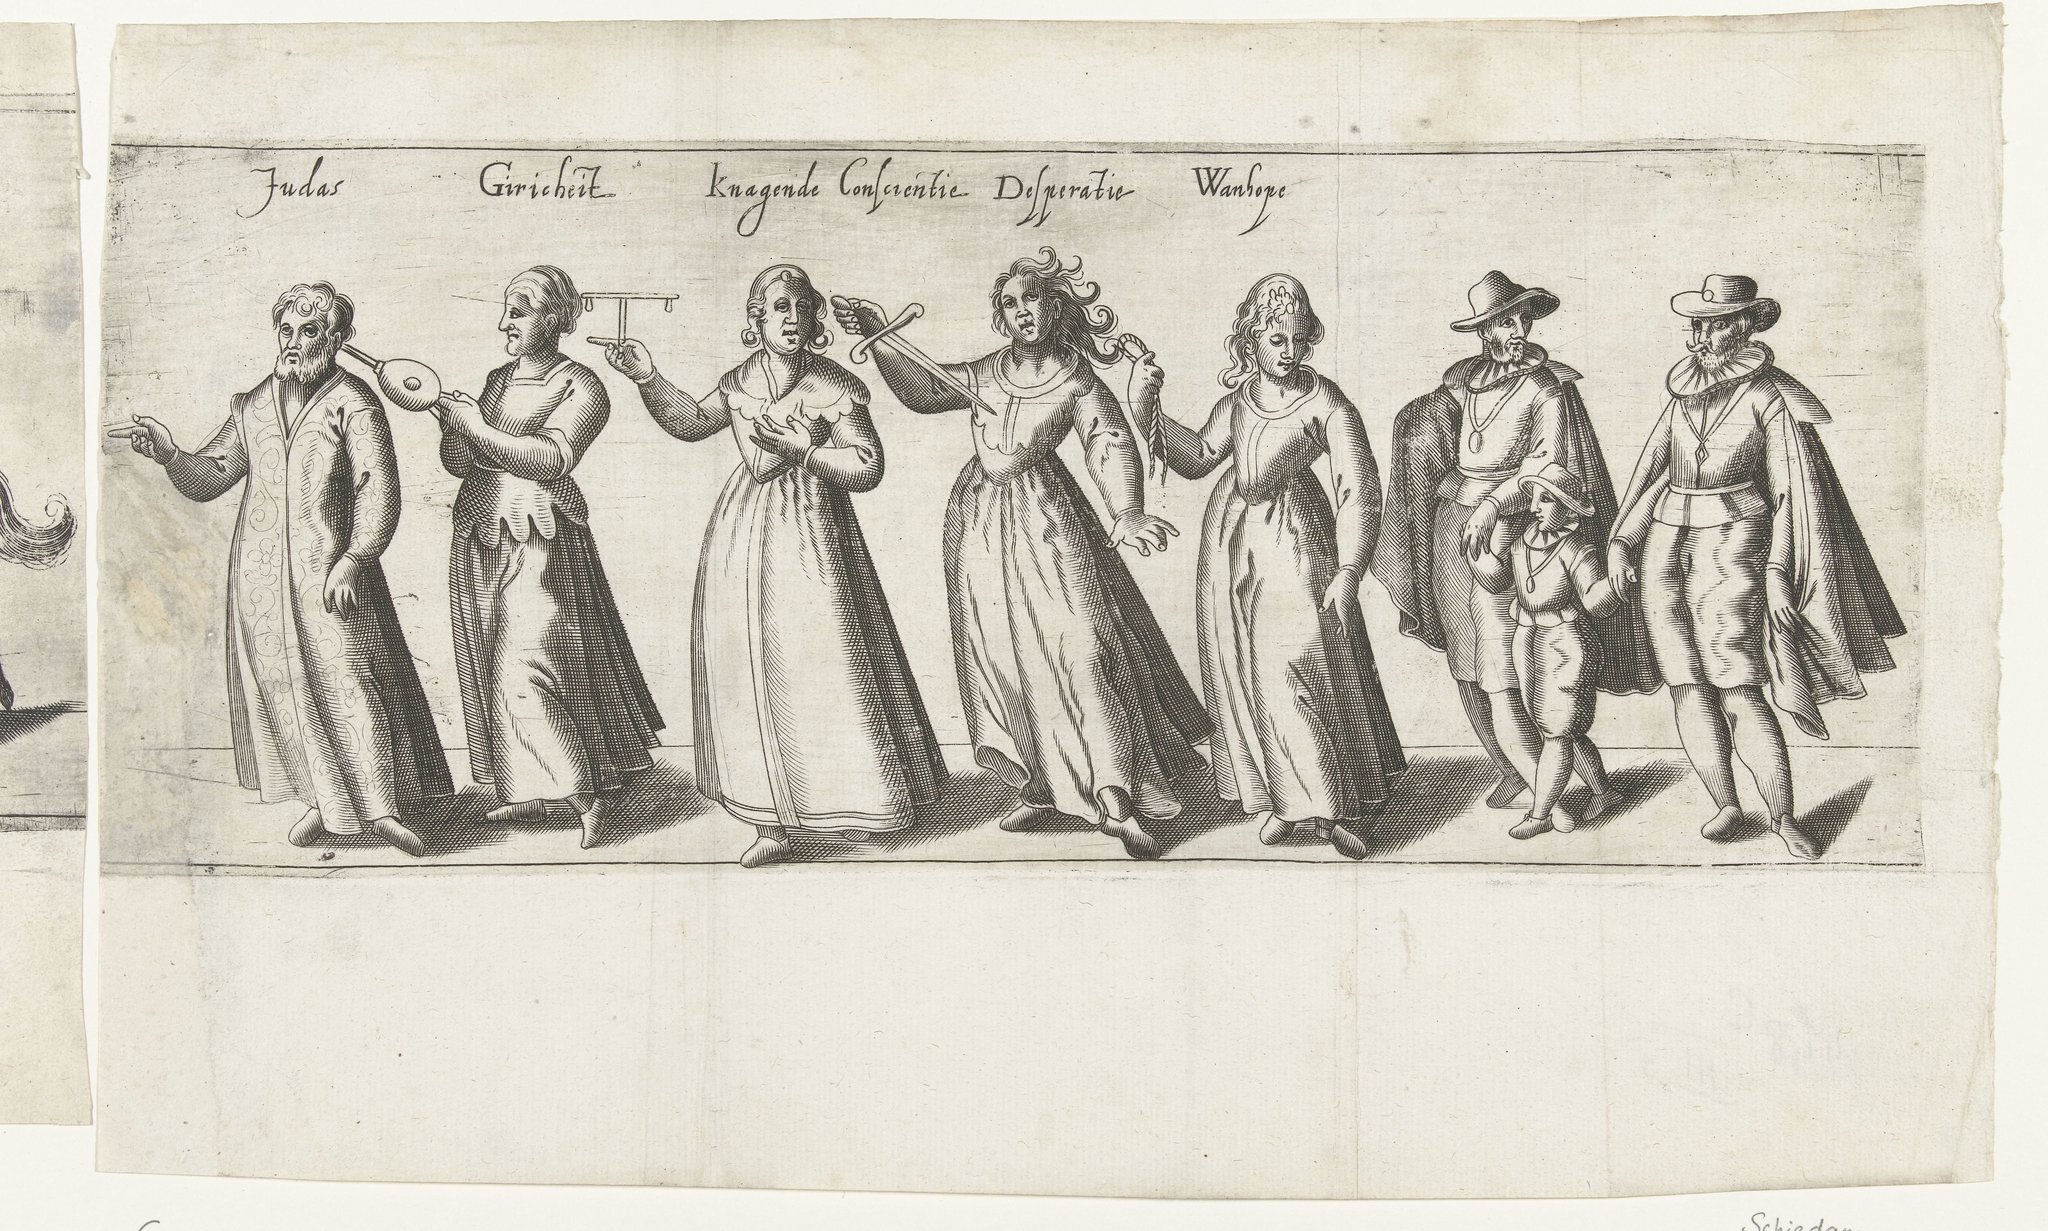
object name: print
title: De intrede van Schiedam verthoont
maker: Anonymous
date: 1607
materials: paper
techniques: engraving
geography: northern netherlands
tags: the good samaritan (luke 10:30-37), chamber of rhetoric (dutch: 'rederijkerskamer'), festivities (+ parade, pageant, cavalcade ~ festive activities), haarlem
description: Gebruikt als illustratie in: Const-thoonende ivweel, by de loflijcke stadt Haerlem, ten versoecke van Trou moet blijcken, in't licht gebracht. : Waer inne duydelick verclaert ende verthoont wordt alles wat den mensche mach wecken om den armen te troosten, ende zijnen naesten by te staen. : In twaelf spelen van sinne ... in redenrijck naar de volgende voorgegevene caerte van 't speel-korenken, Zacharias Heyns, Zwolle 1607. Los fragment, bedoeld om samen met de andere delen tot een fries gemonteerd te worden.